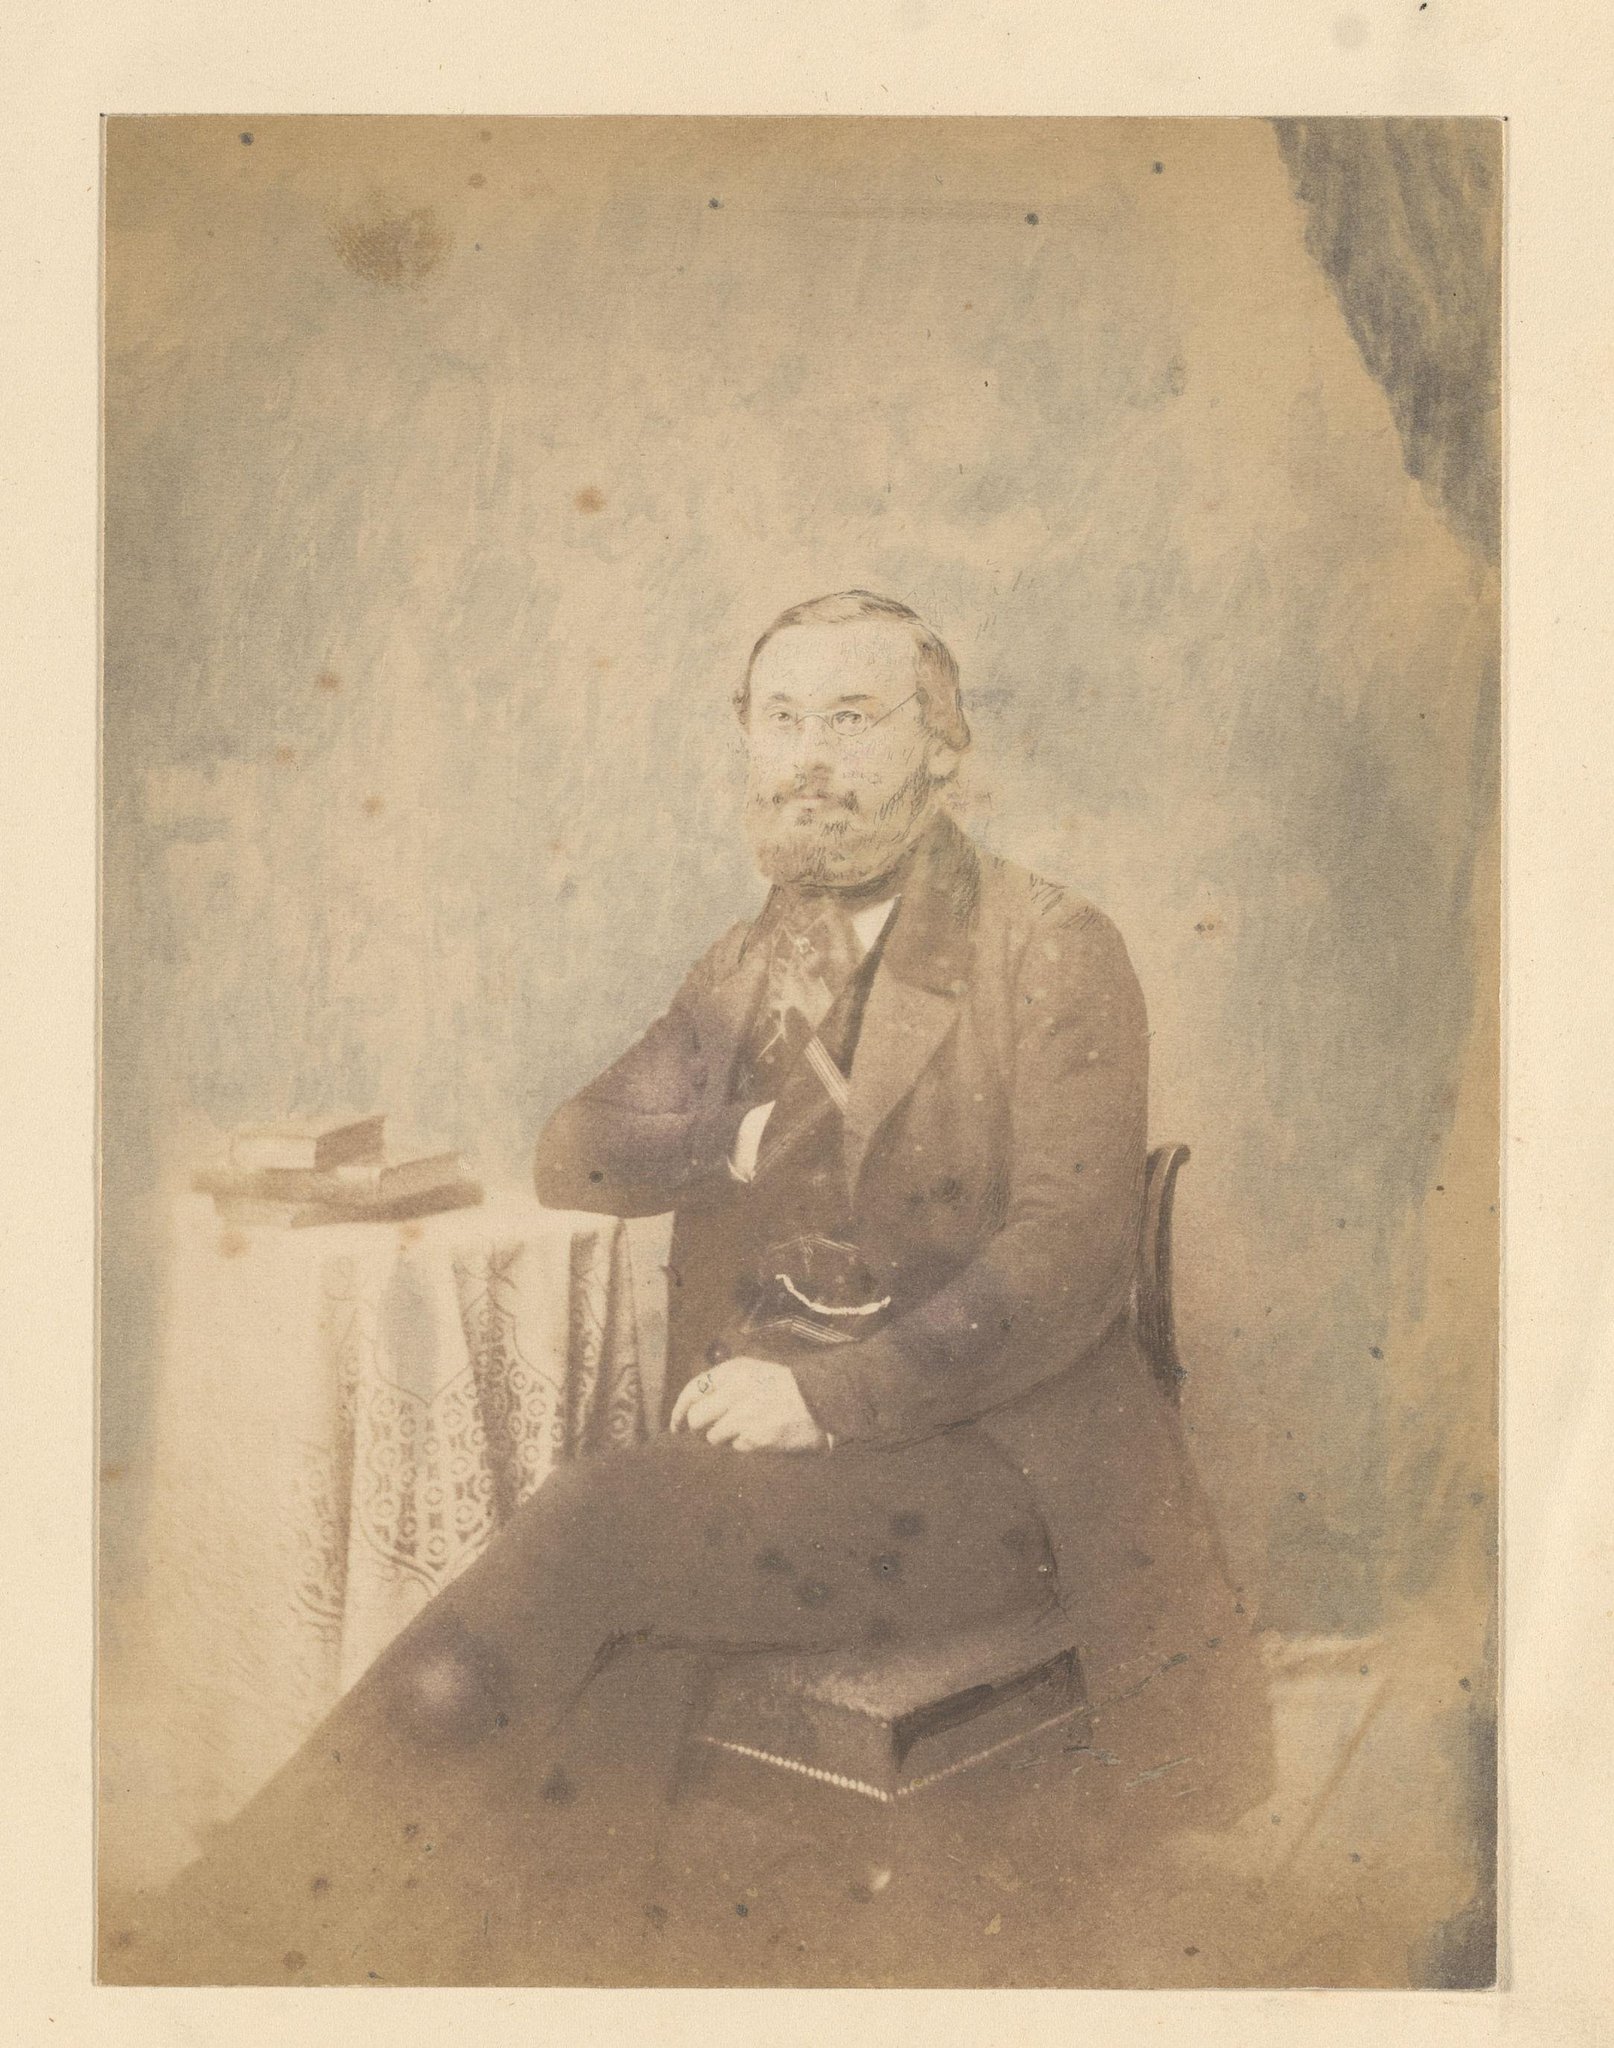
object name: photograph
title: Portret van een onbekende man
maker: eduard isaac asser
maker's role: amateurfotograaf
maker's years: 1809-1894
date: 1848-1855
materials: paper, photographic support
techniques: salted paper print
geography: amsterdam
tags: muntplein (amsterdam), singel, reguliersbreestraat